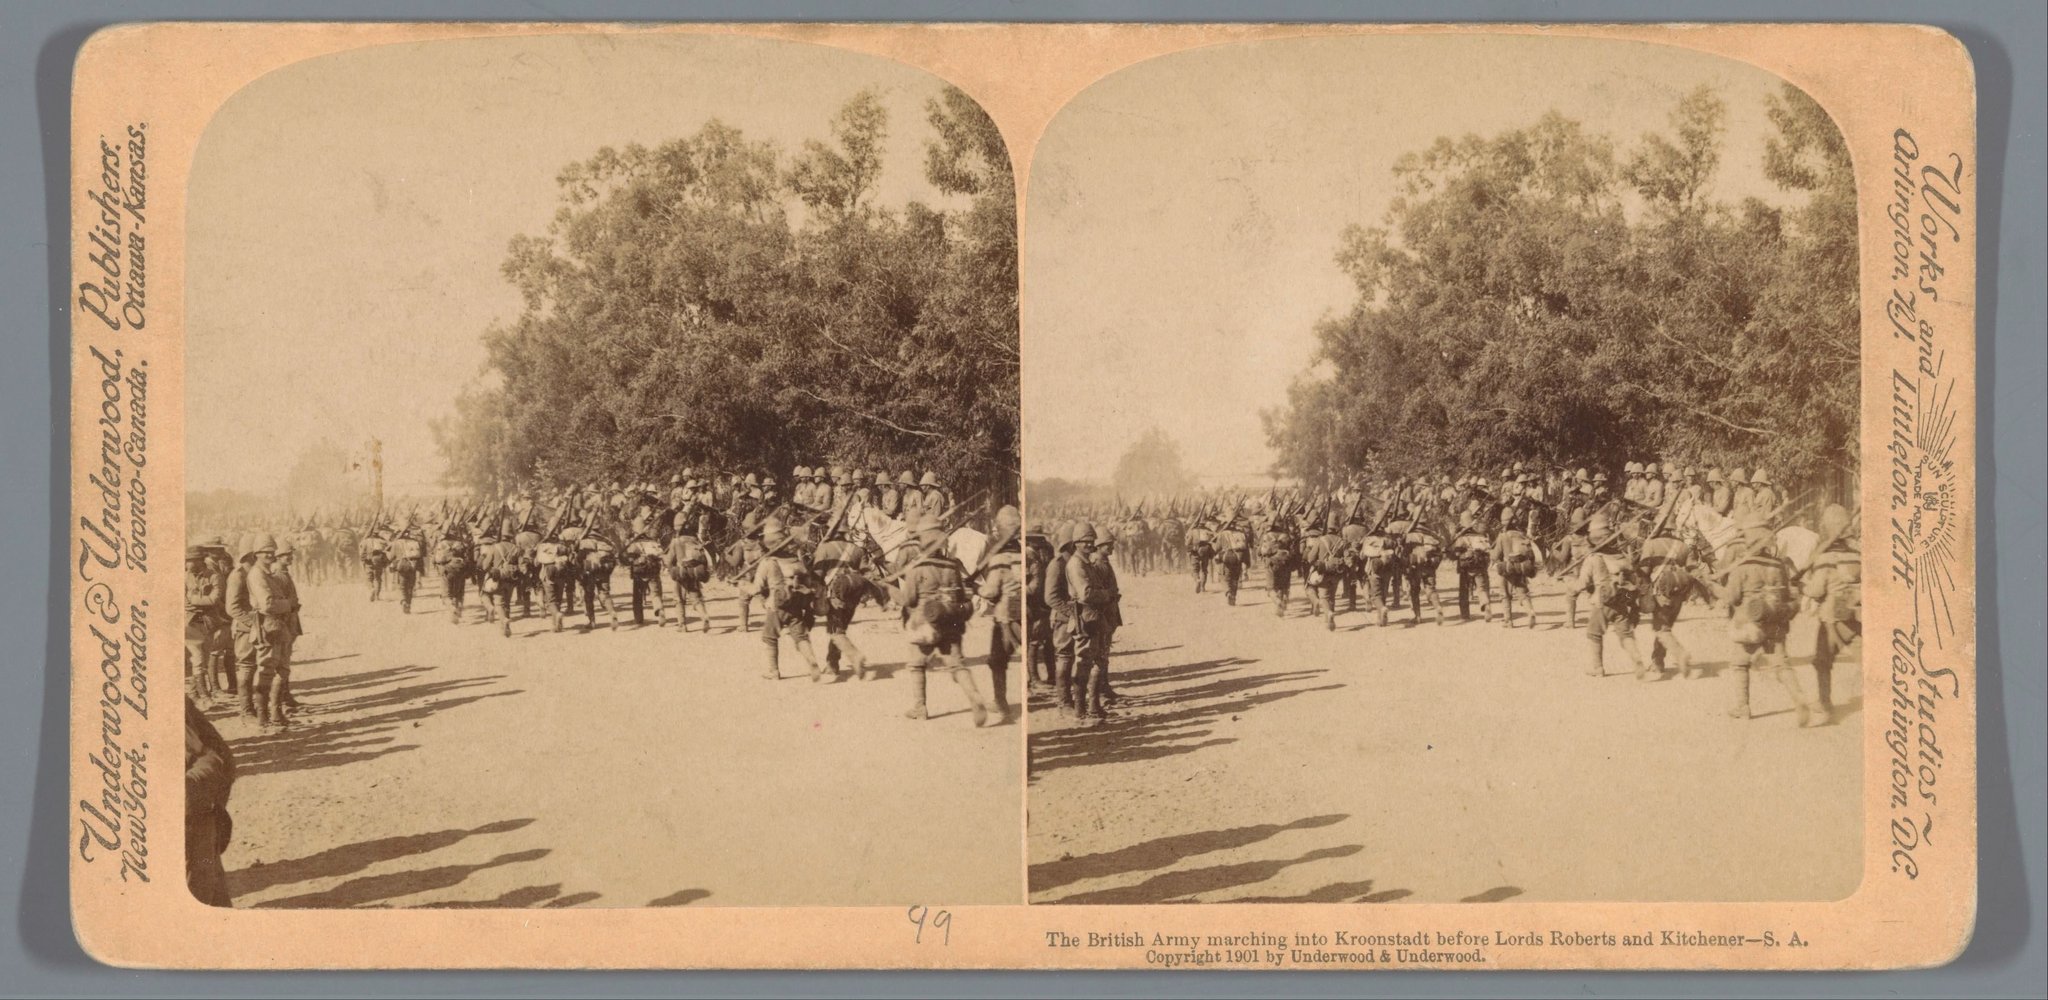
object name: stereograph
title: The British Army marching into Kroonstadt before Lords Roberts and Kitchener, S.A.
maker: Anonymous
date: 1901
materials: cardboard, paper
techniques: albumen print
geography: new york city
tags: marching away (troops)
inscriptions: inscription: ‘Works and Studios ~/ Arlington, N.J. Littleton, N.H. Washington, D.C.’, number: ‘99’, inscription, copyright notice: ‘Copyright 1901 by Underwood & Underwood.’